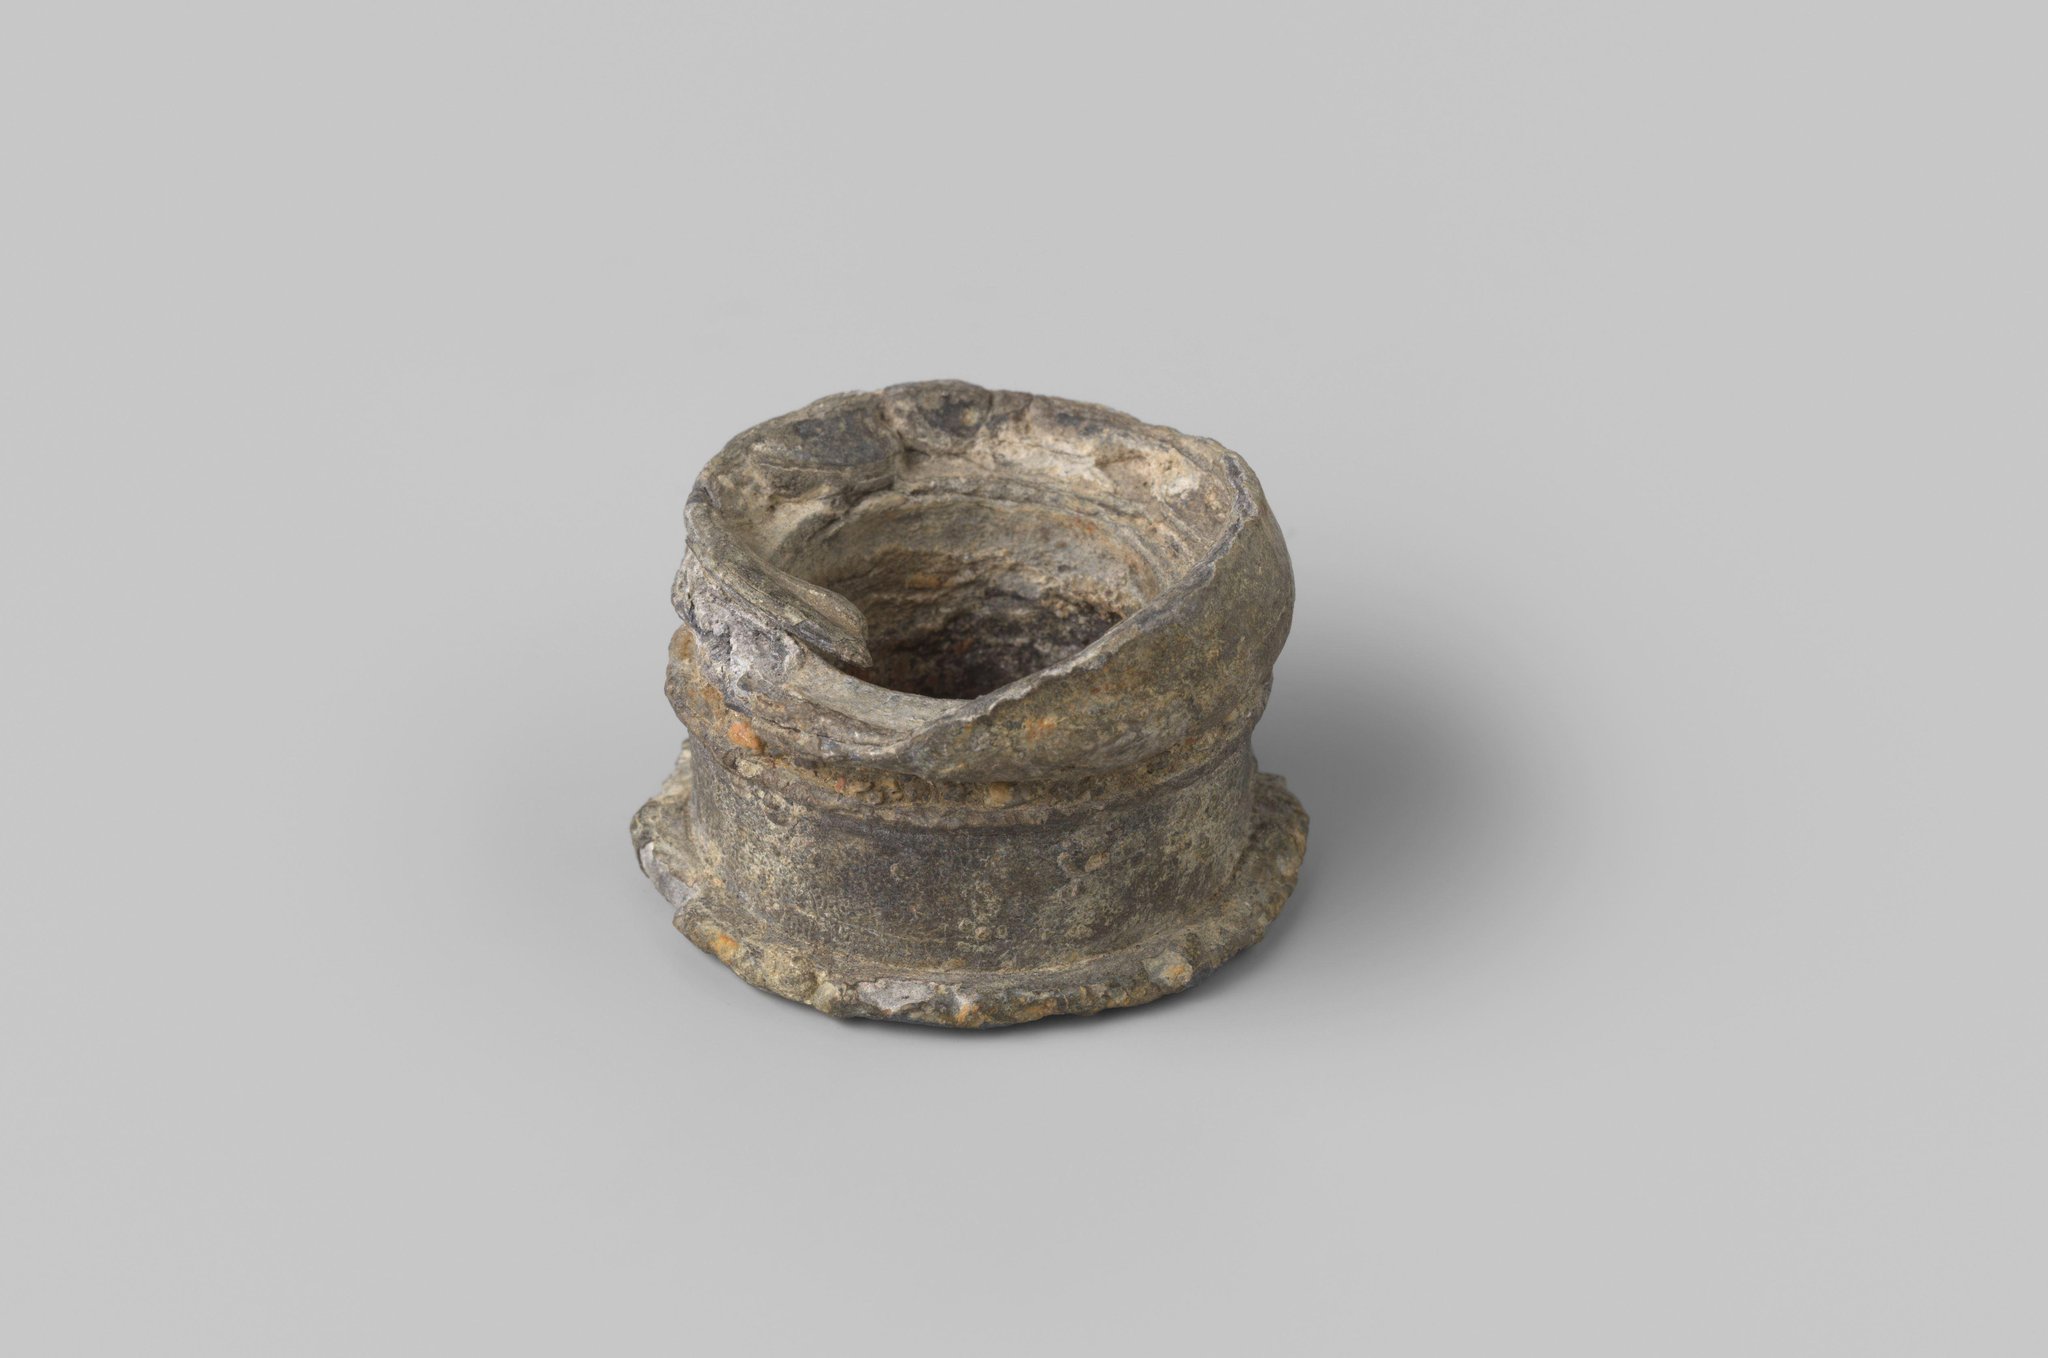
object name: verpakking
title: Schroeffitting uit het wrak van de Oost-Indiëvaarder Hollandia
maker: Anonymous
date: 1700-1743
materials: tin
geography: netherlands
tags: verenigde oostindische compagnie, hollandia (schip), annet